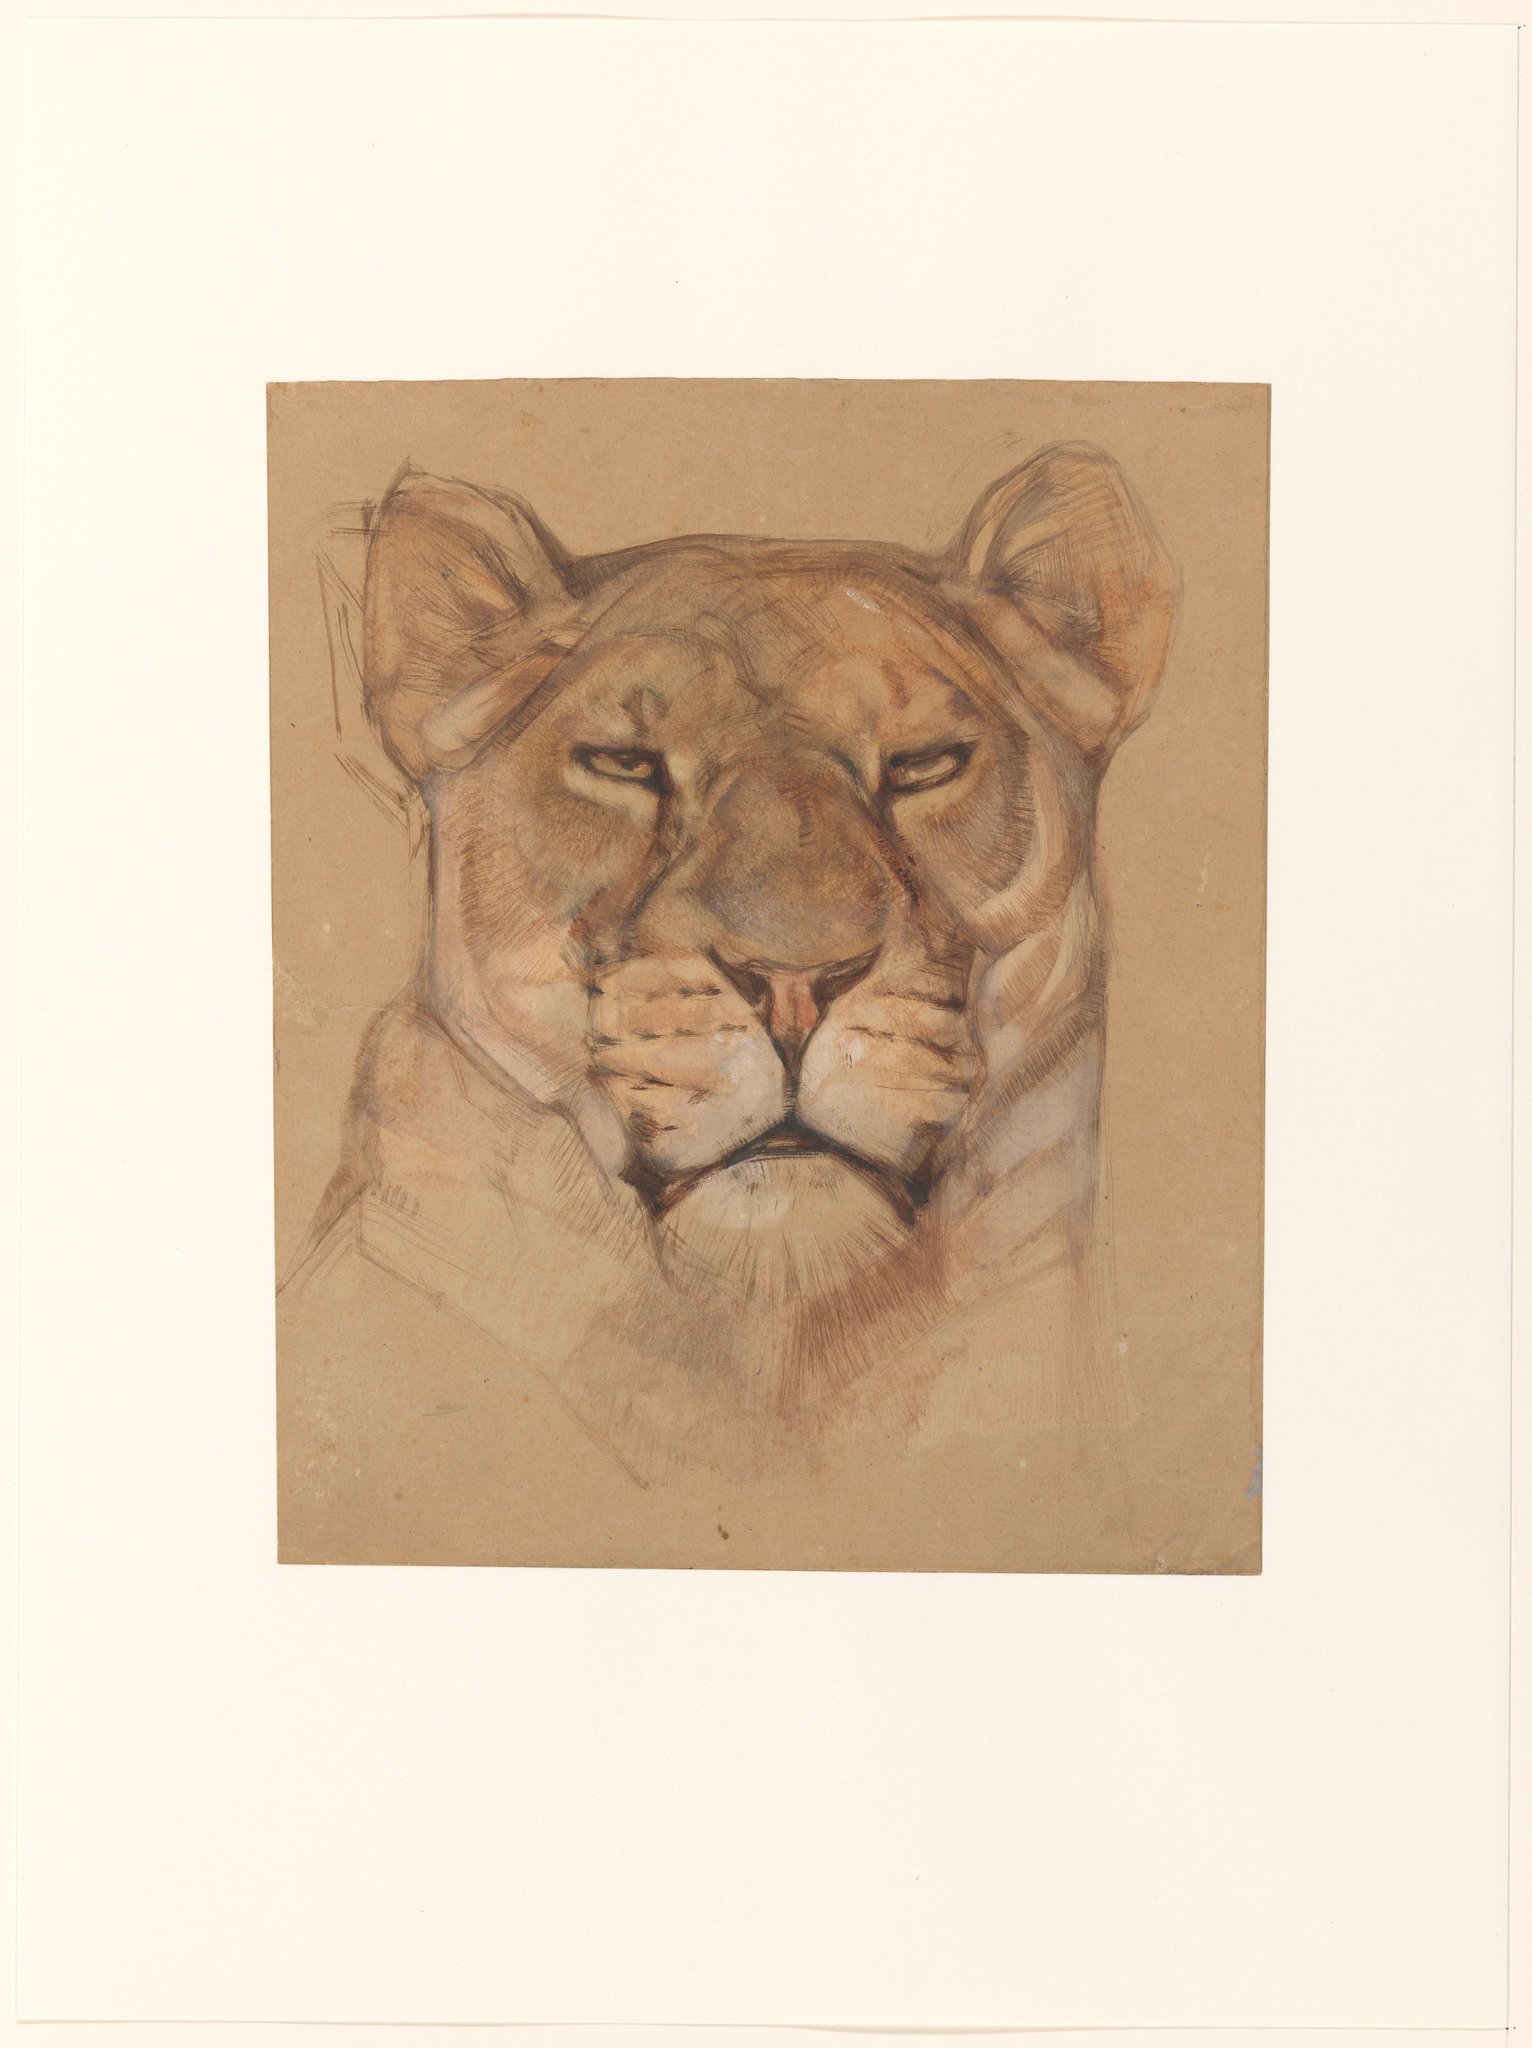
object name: watercolor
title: Kop leeuwin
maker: bernard willem wierink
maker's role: draughtsman, print maker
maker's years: 1856-1939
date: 1866-1939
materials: paper, watercolor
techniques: brush